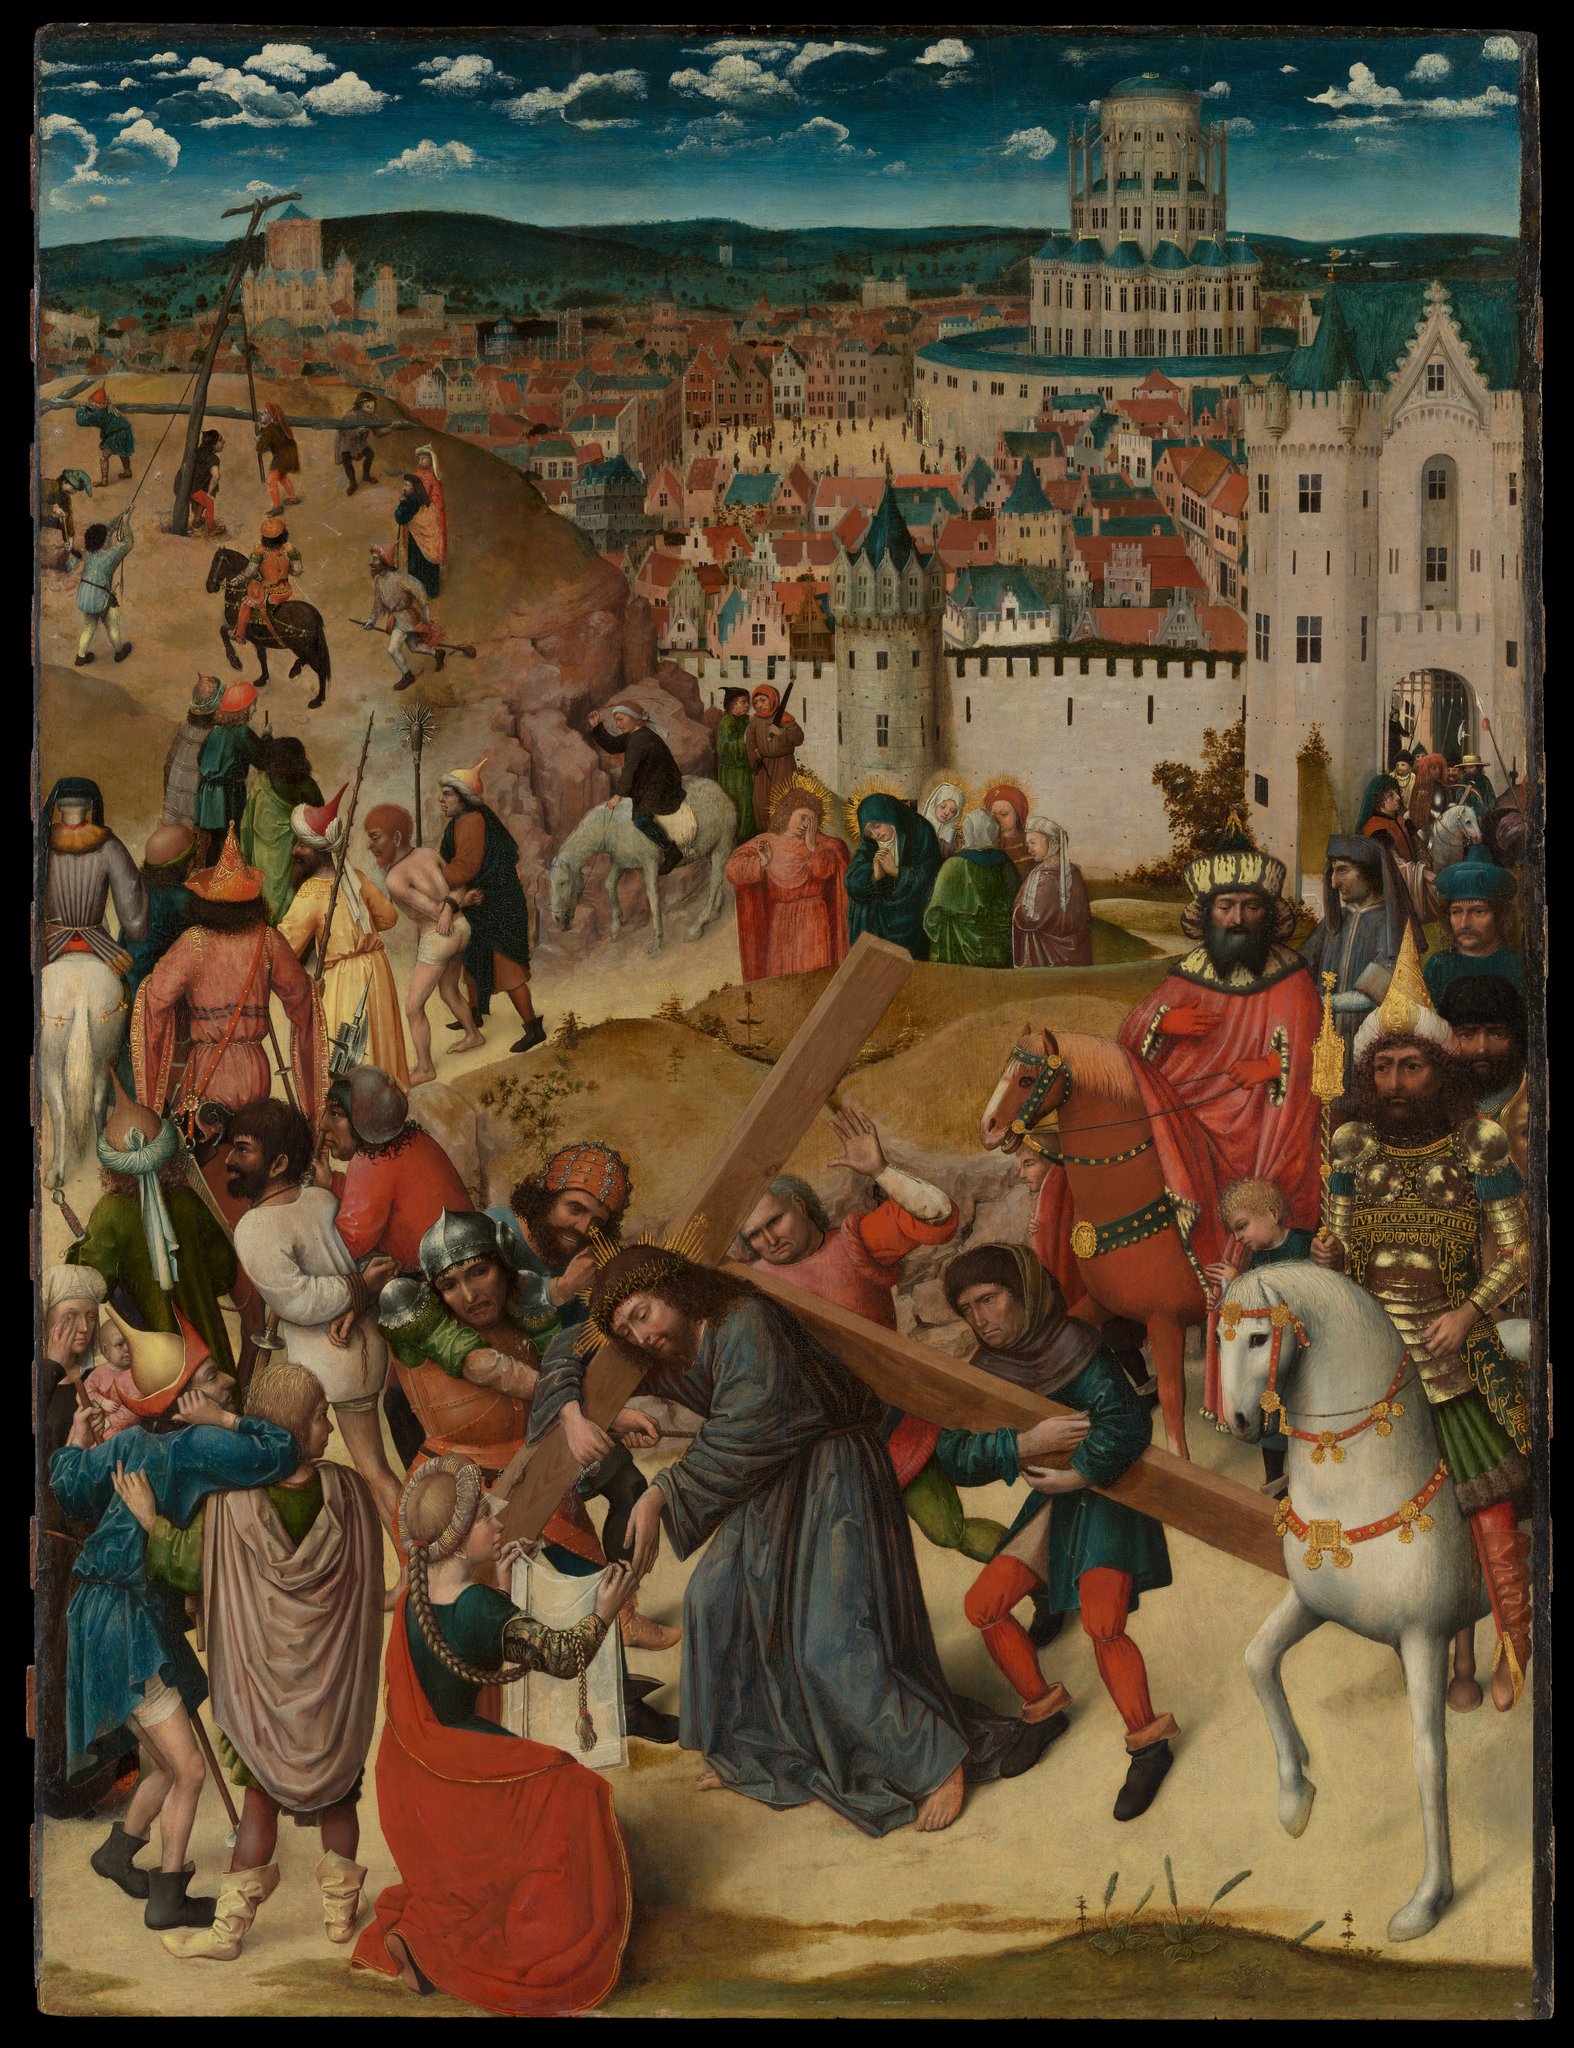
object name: painting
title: Christ Bearing the Cross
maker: north netherlandish (bruges) painter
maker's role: artist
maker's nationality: netherlandish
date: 1465-1475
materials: oil, wood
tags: towns,horses,christ,bearing the cross,crowd